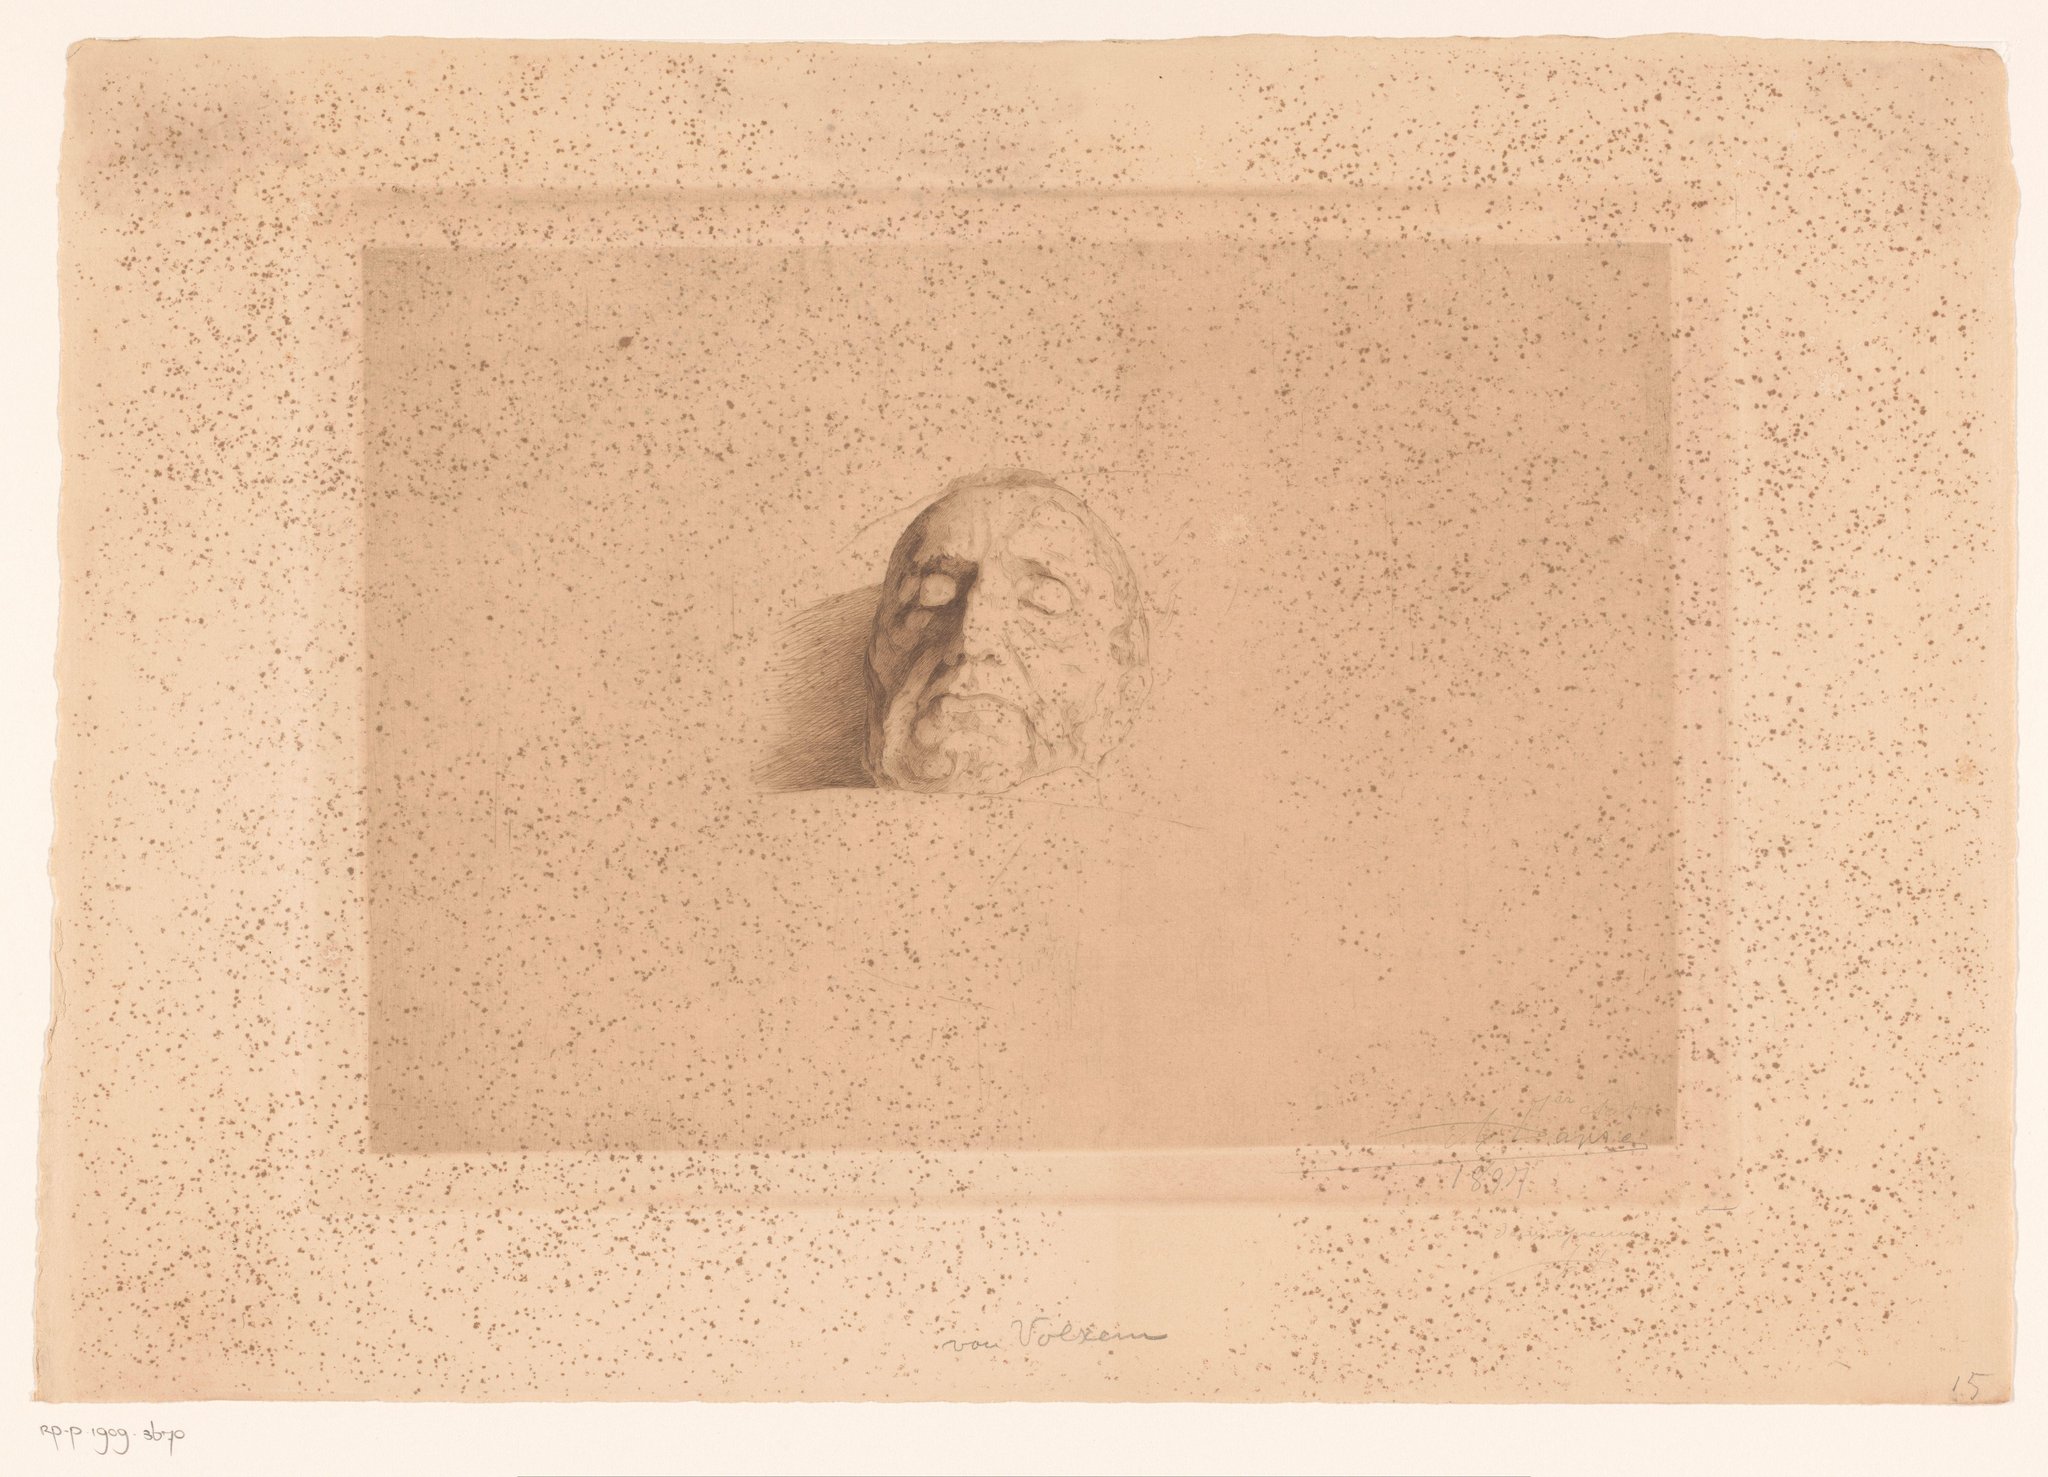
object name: print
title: Portret van een onbekende man op zijn sterfbed, mogelijk Van Volxem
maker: auguste danse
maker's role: print maker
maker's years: 1829-1929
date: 1897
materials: paper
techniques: etching, intaglio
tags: death in old age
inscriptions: collector's mark: Lugt 2228, annotation: ‘1er etat’